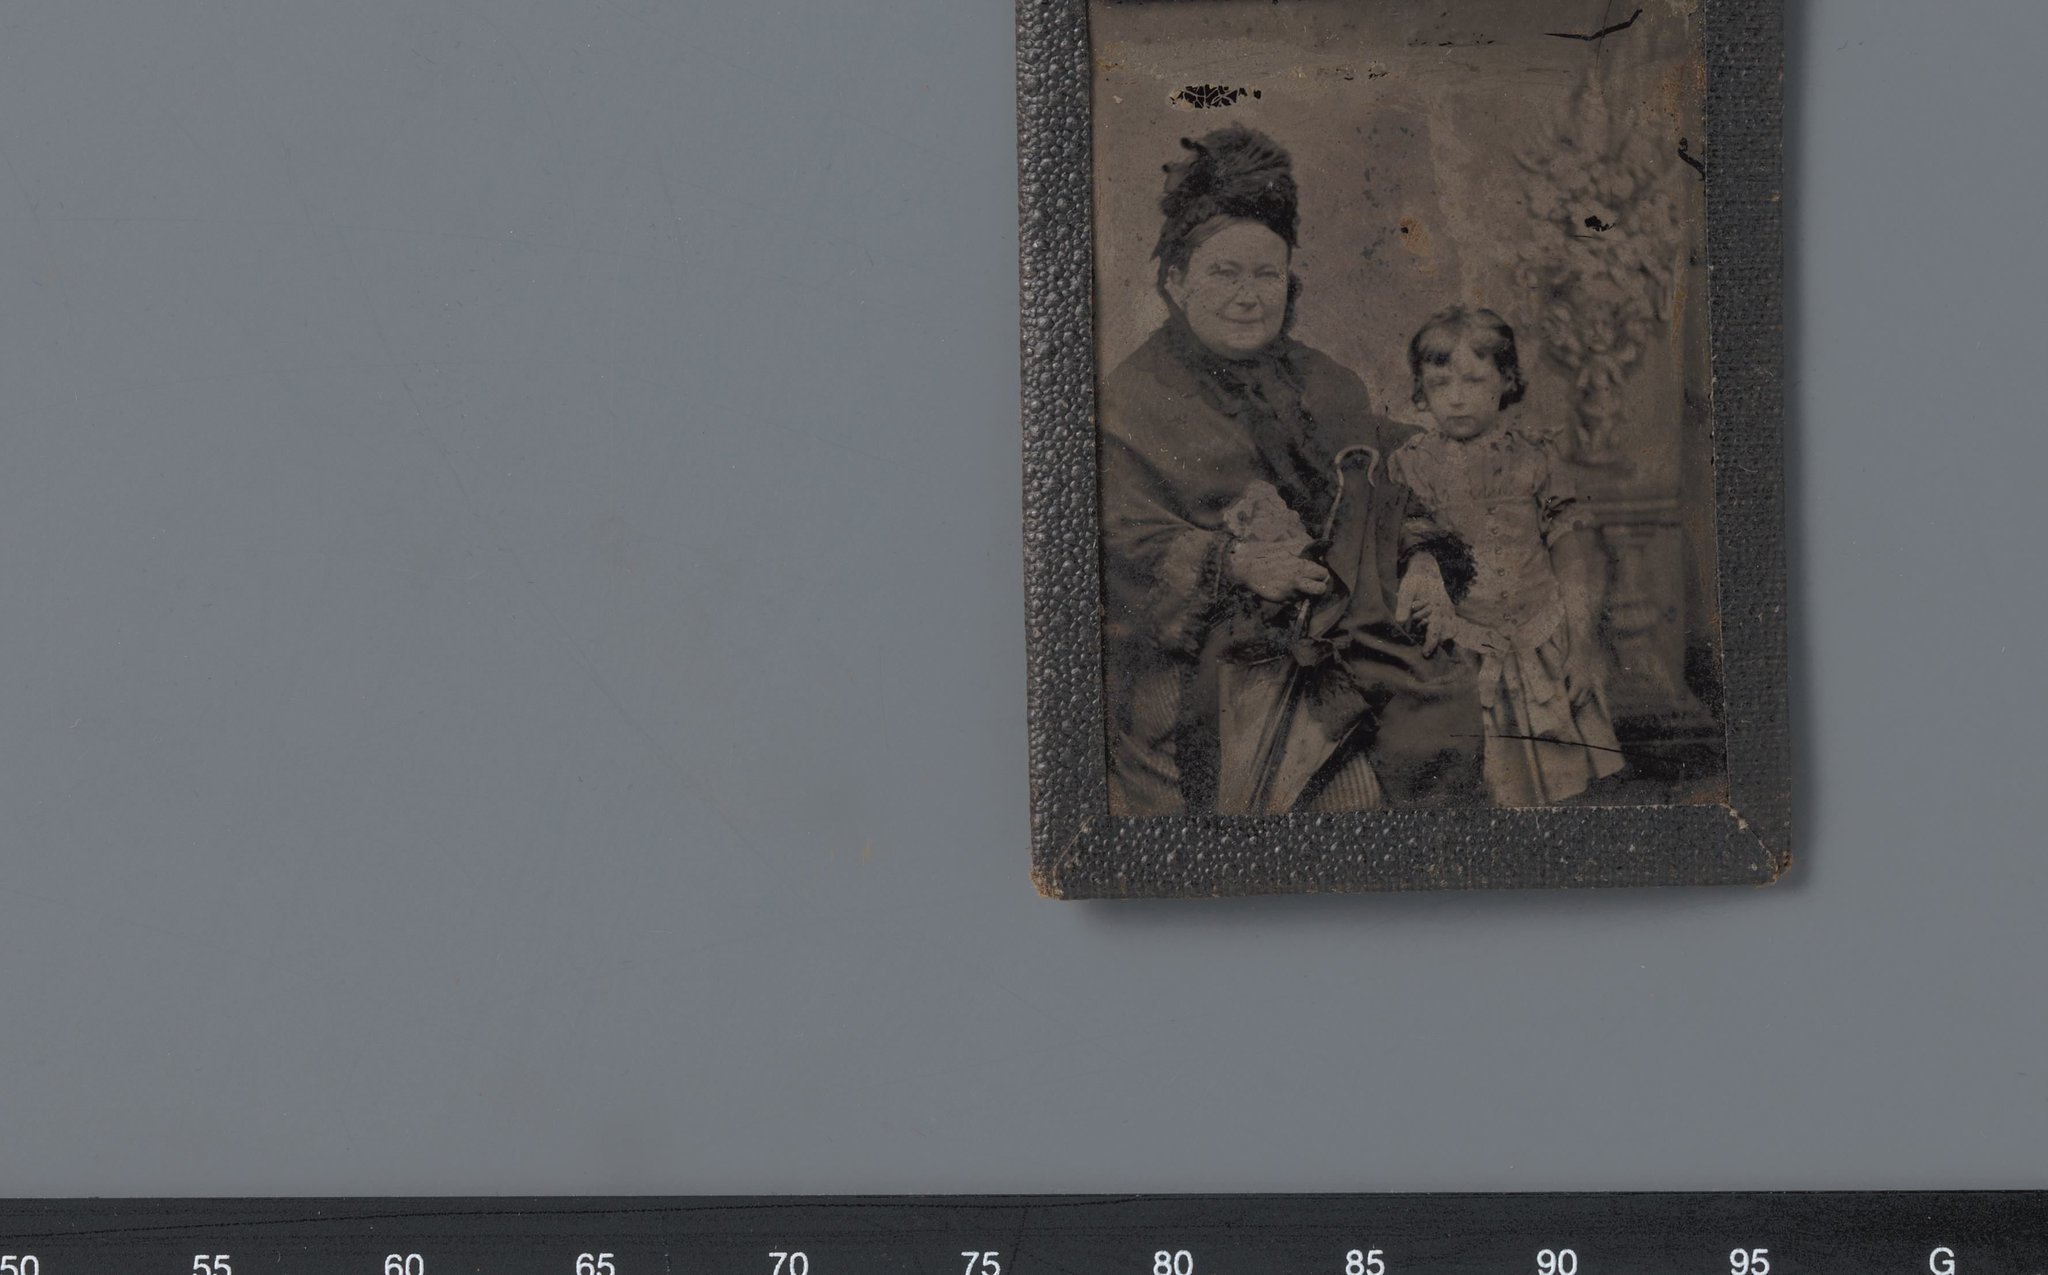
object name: photograph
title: Portret van Elisabeth Catharina Broers en haar grootmoeder Geertruida van Pesch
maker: Anonymous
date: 1900-1910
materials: iron, paper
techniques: ferrotyping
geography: netherlands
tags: leiden, historical persons - bb - woman, girl (child between toddler and youth)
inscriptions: annotation: ‘Elisabeth/ Catharina/ Broers/ dochter van/ Jacob Cornelis Br/ en/ Geertruide van/ Pesch’